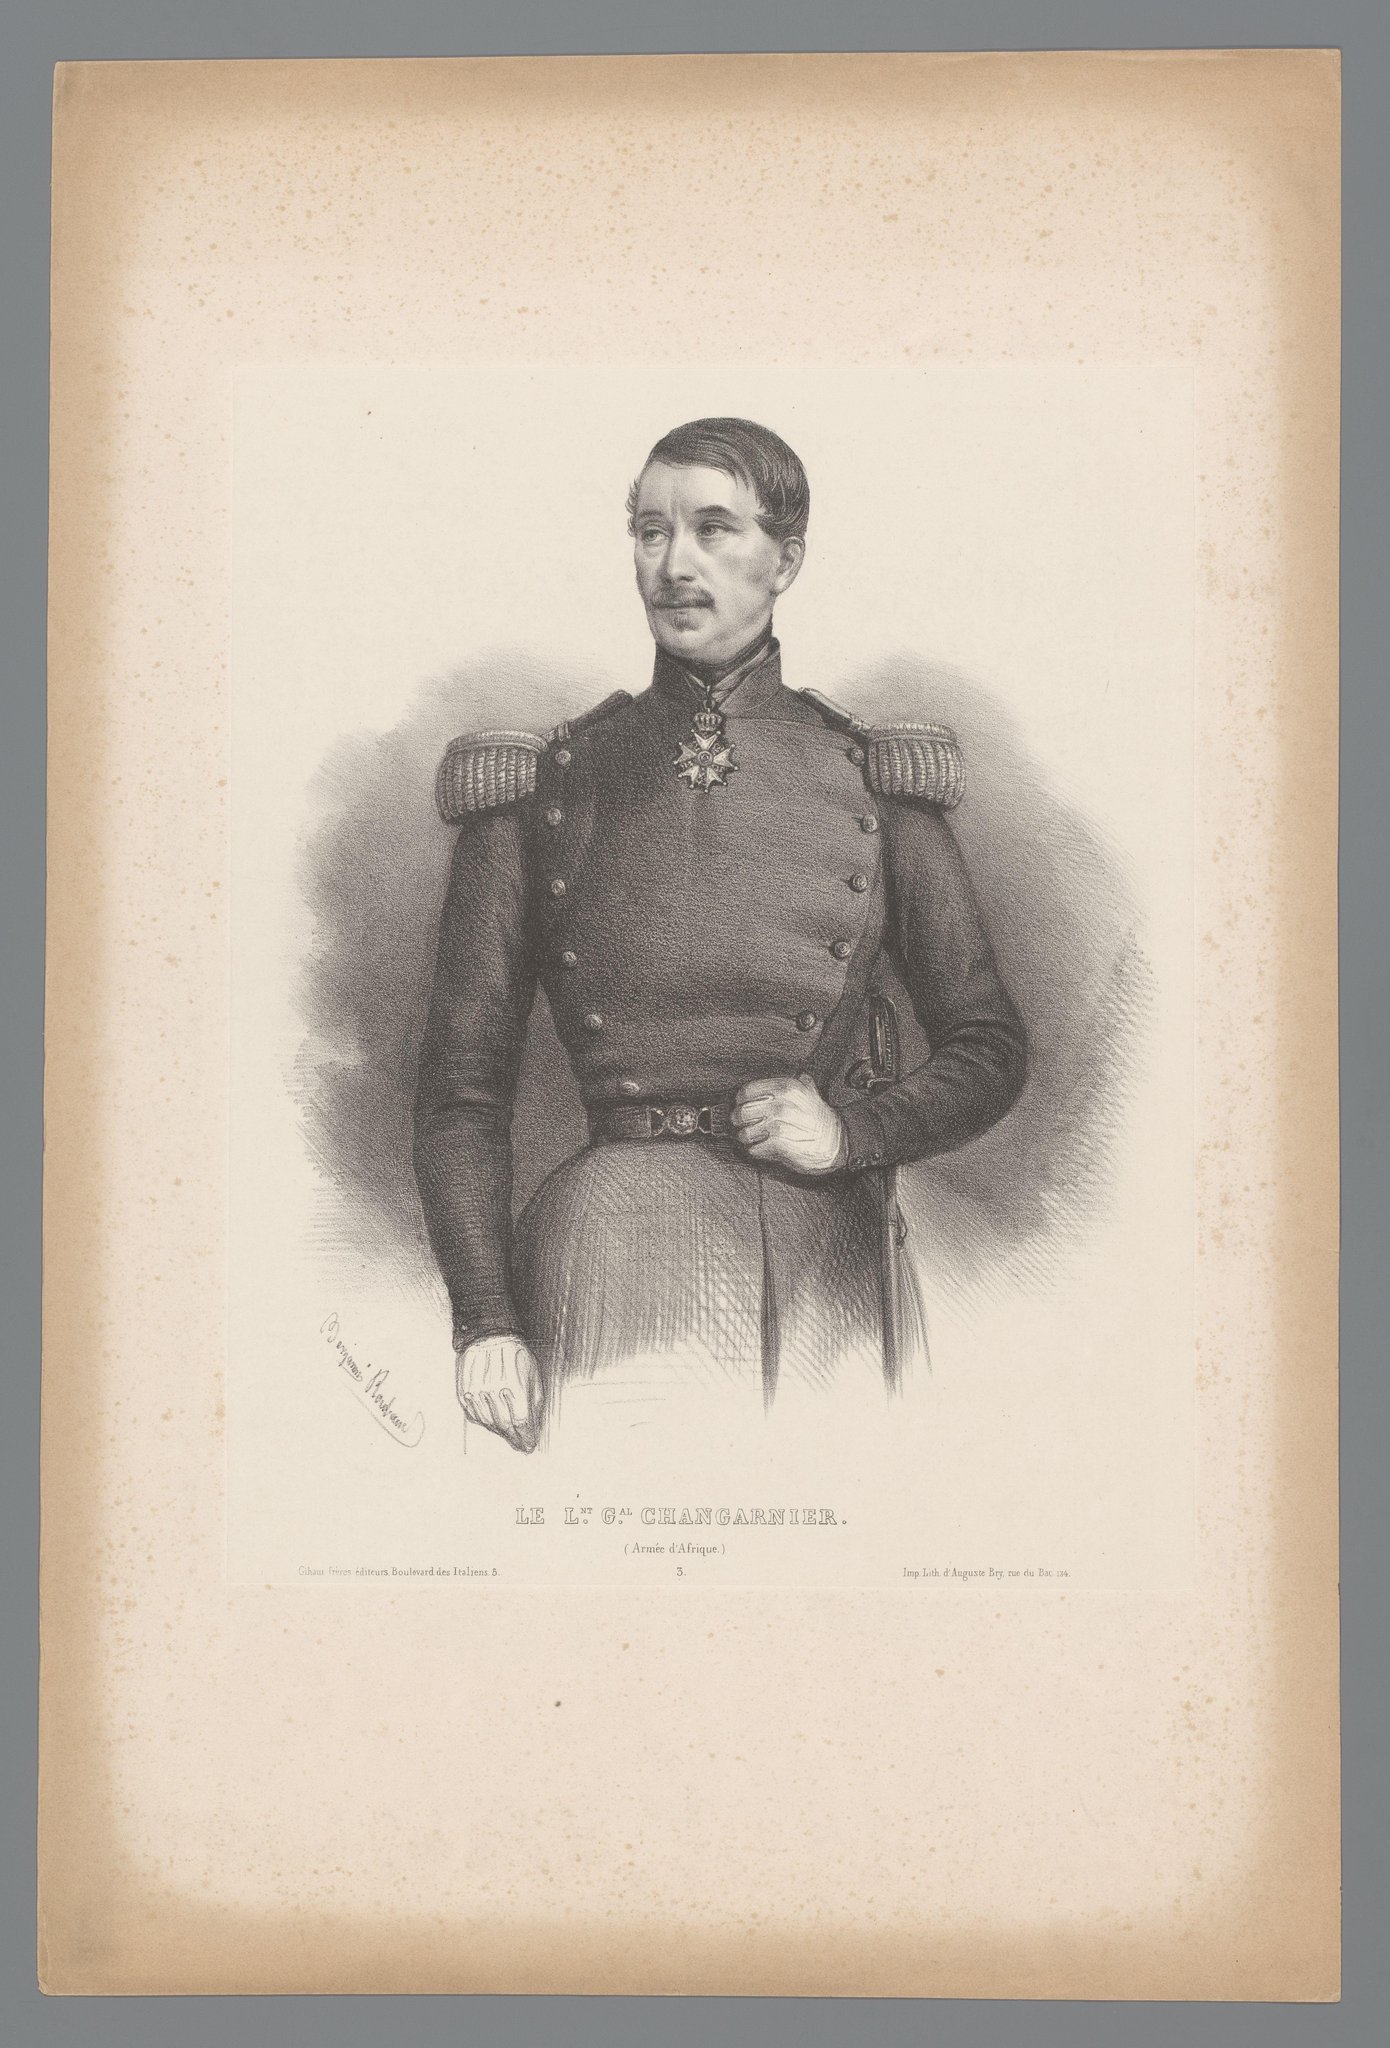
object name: print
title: Portret van generaal Changarnier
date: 1842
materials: paper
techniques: lithograph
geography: paris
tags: commander-in-chief, general, marshal, historical persons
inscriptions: collector's mark: Lugt 2228